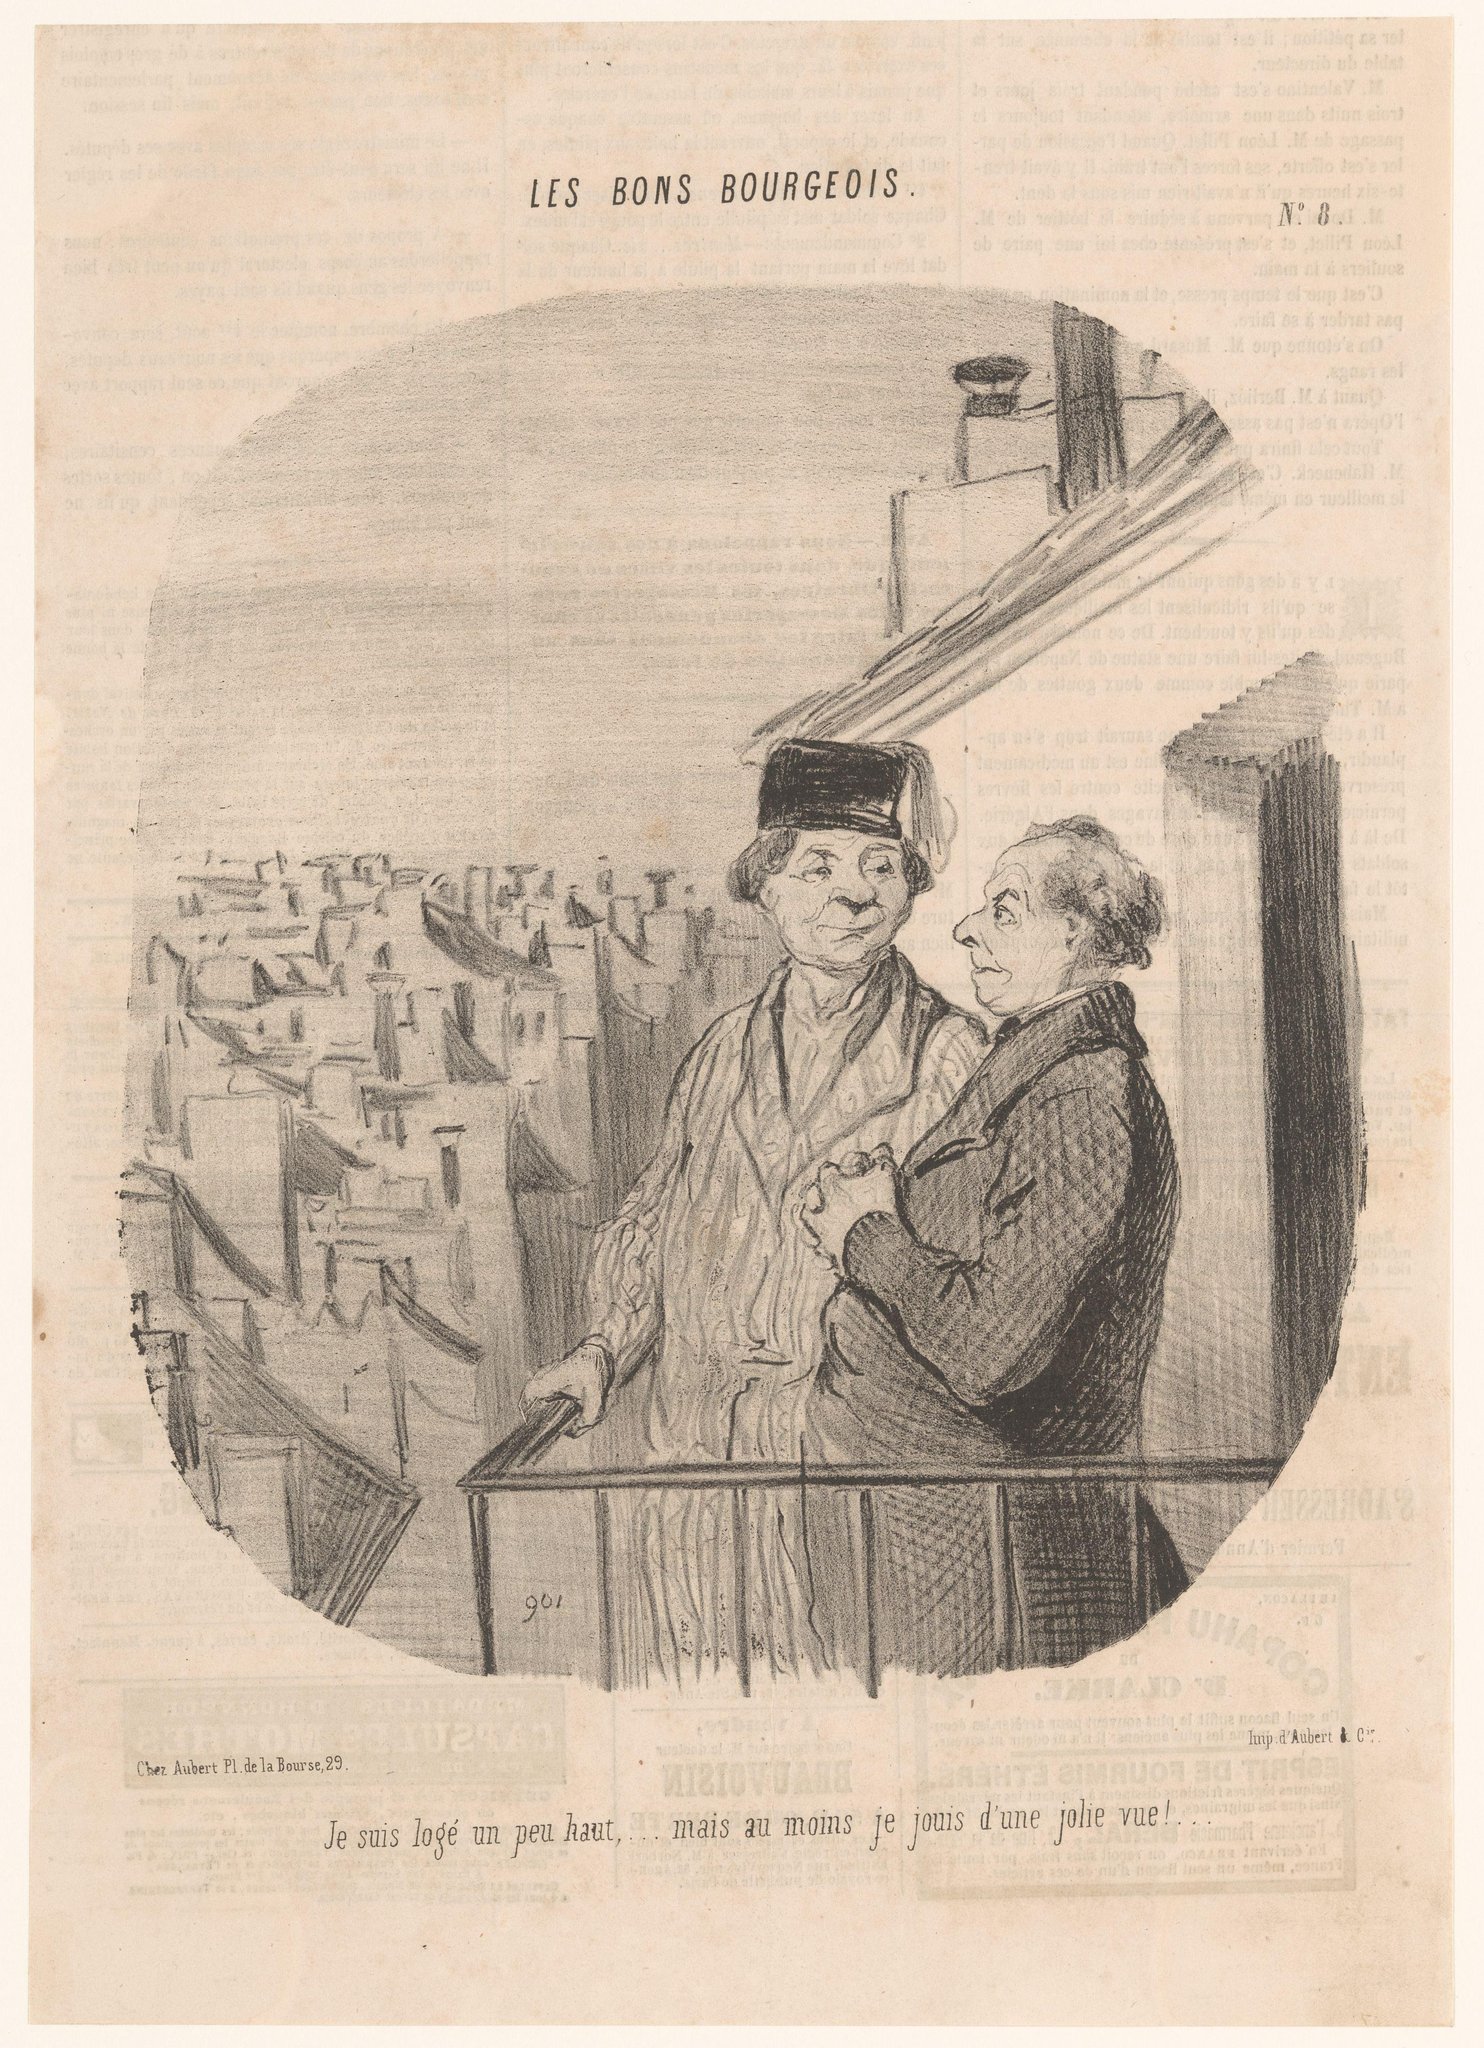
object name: cartoon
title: Les bons bourgeois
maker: honoré daumier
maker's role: draughtsman, painter, print maker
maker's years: 1808-1879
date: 1846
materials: paper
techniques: lithograph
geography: paris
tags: caricatures (human types), balcony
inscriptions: collector's mark: Lugt 2228a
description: Prent gebruikt voor: Le Charivari, 15-07-1846.